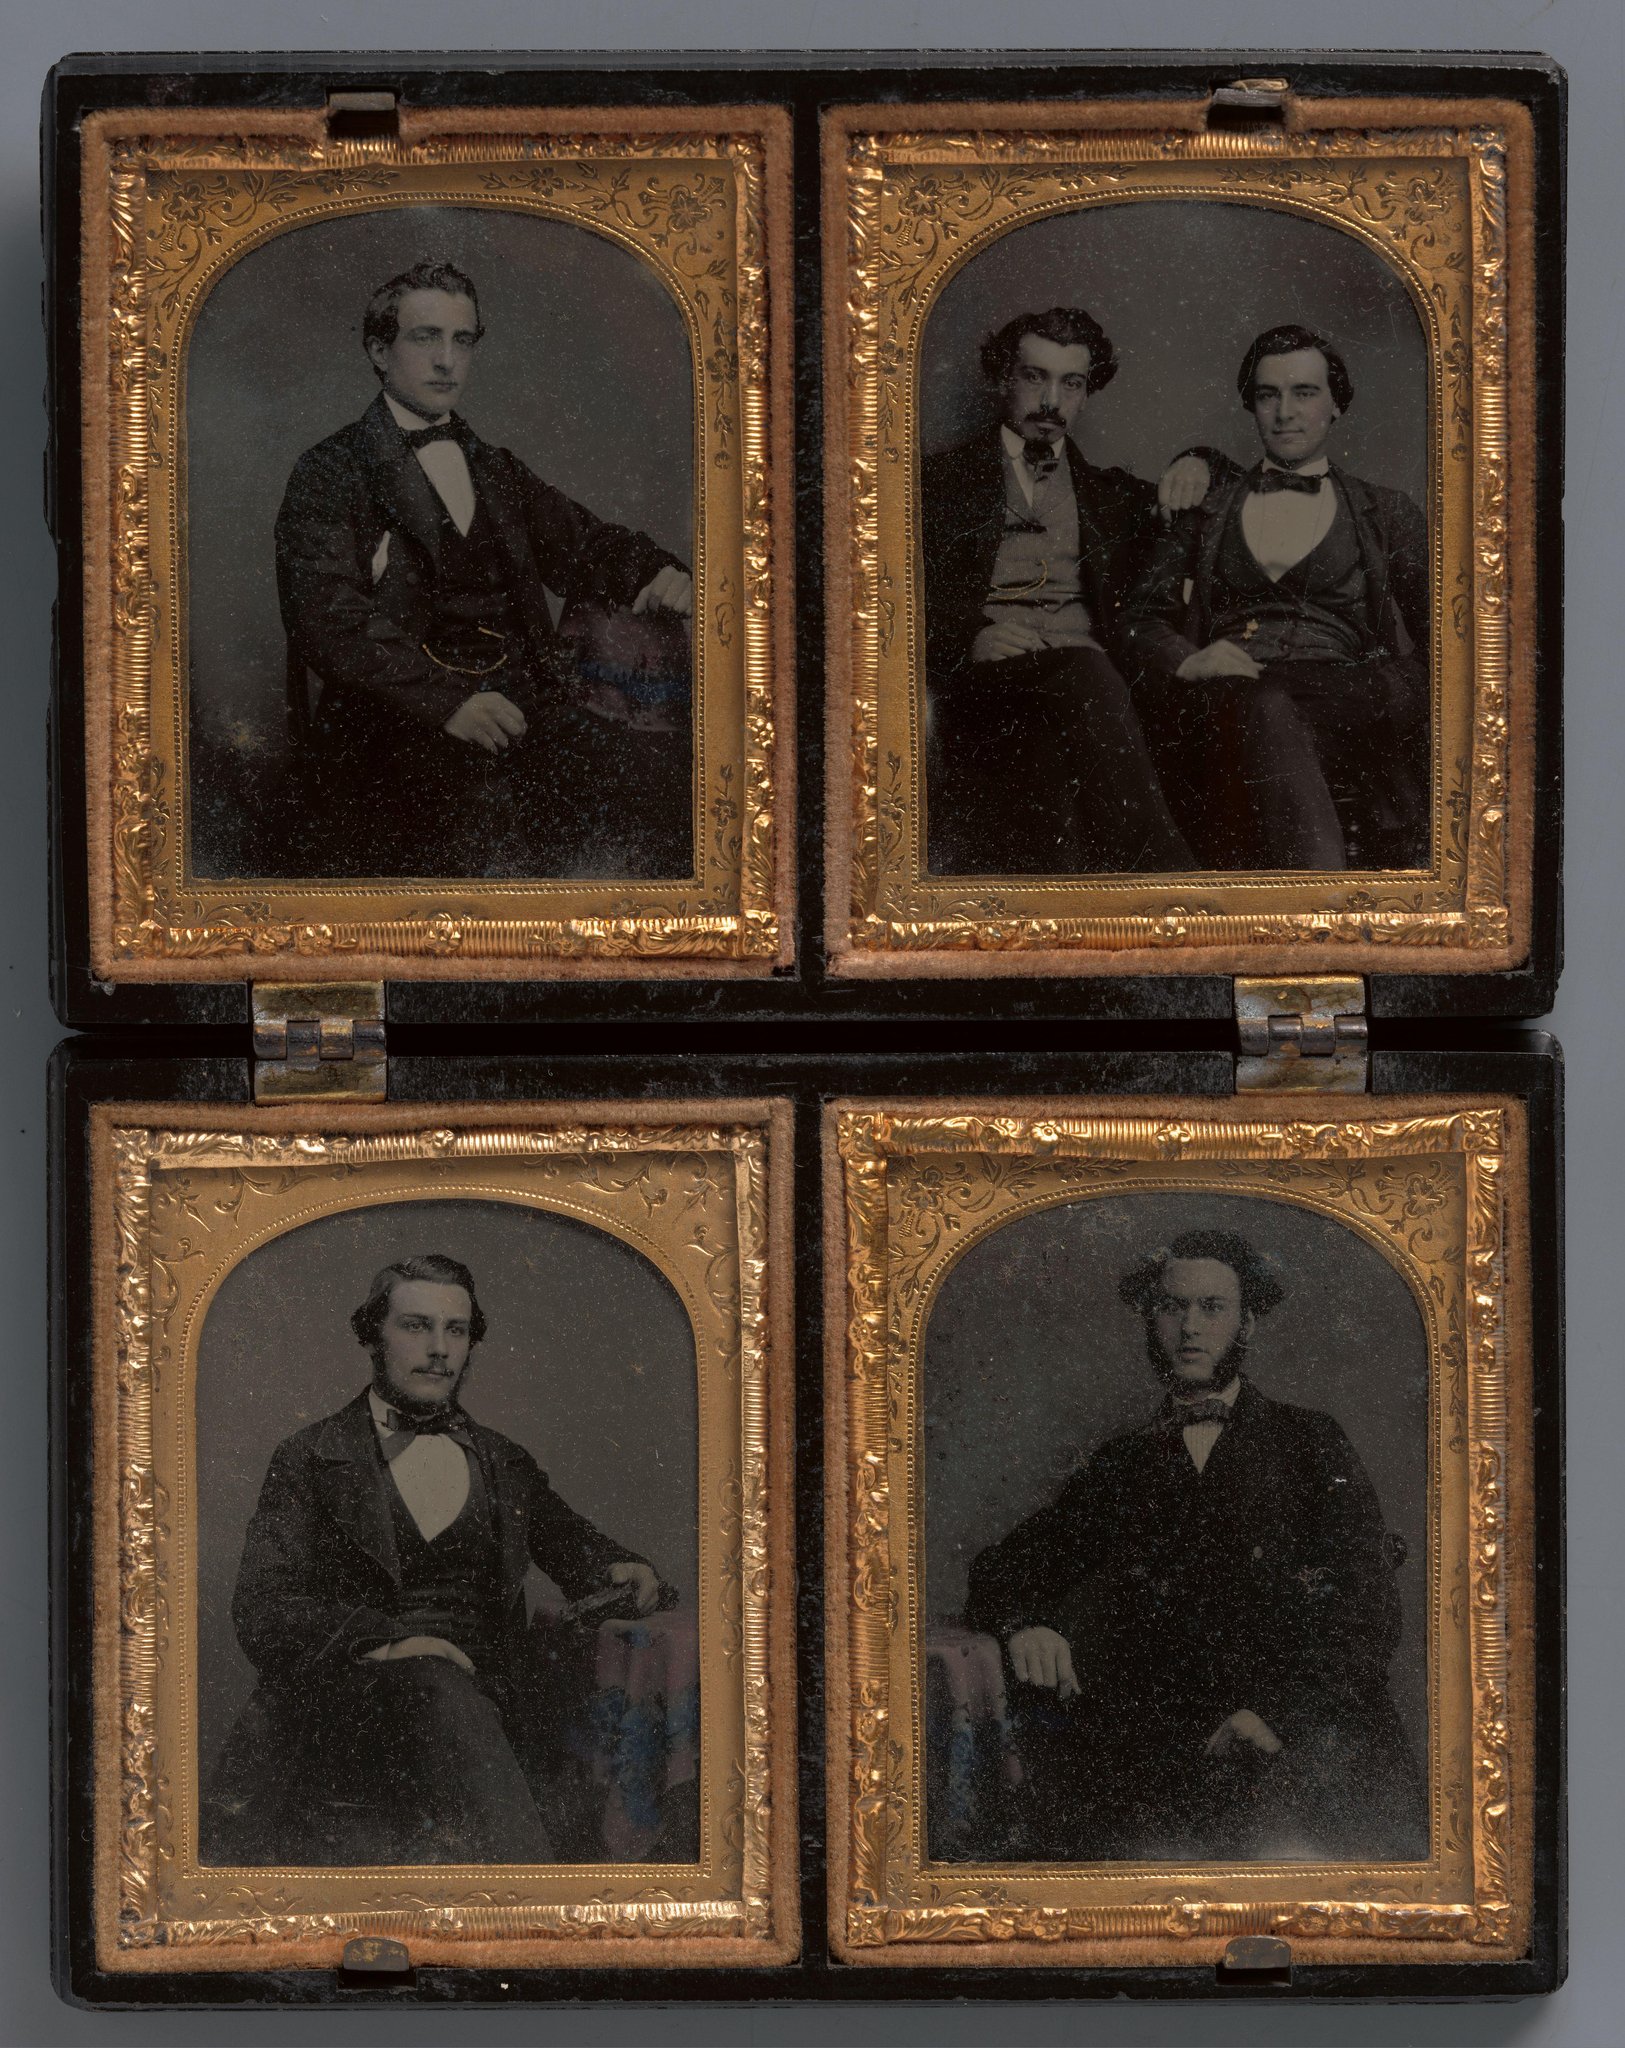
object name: union case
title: Portret van een zittende onbekende jongeman met baard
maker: Anonymous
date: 1859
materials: glass, metal, plastic, textile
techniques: ambrotype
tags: historical persons, beard